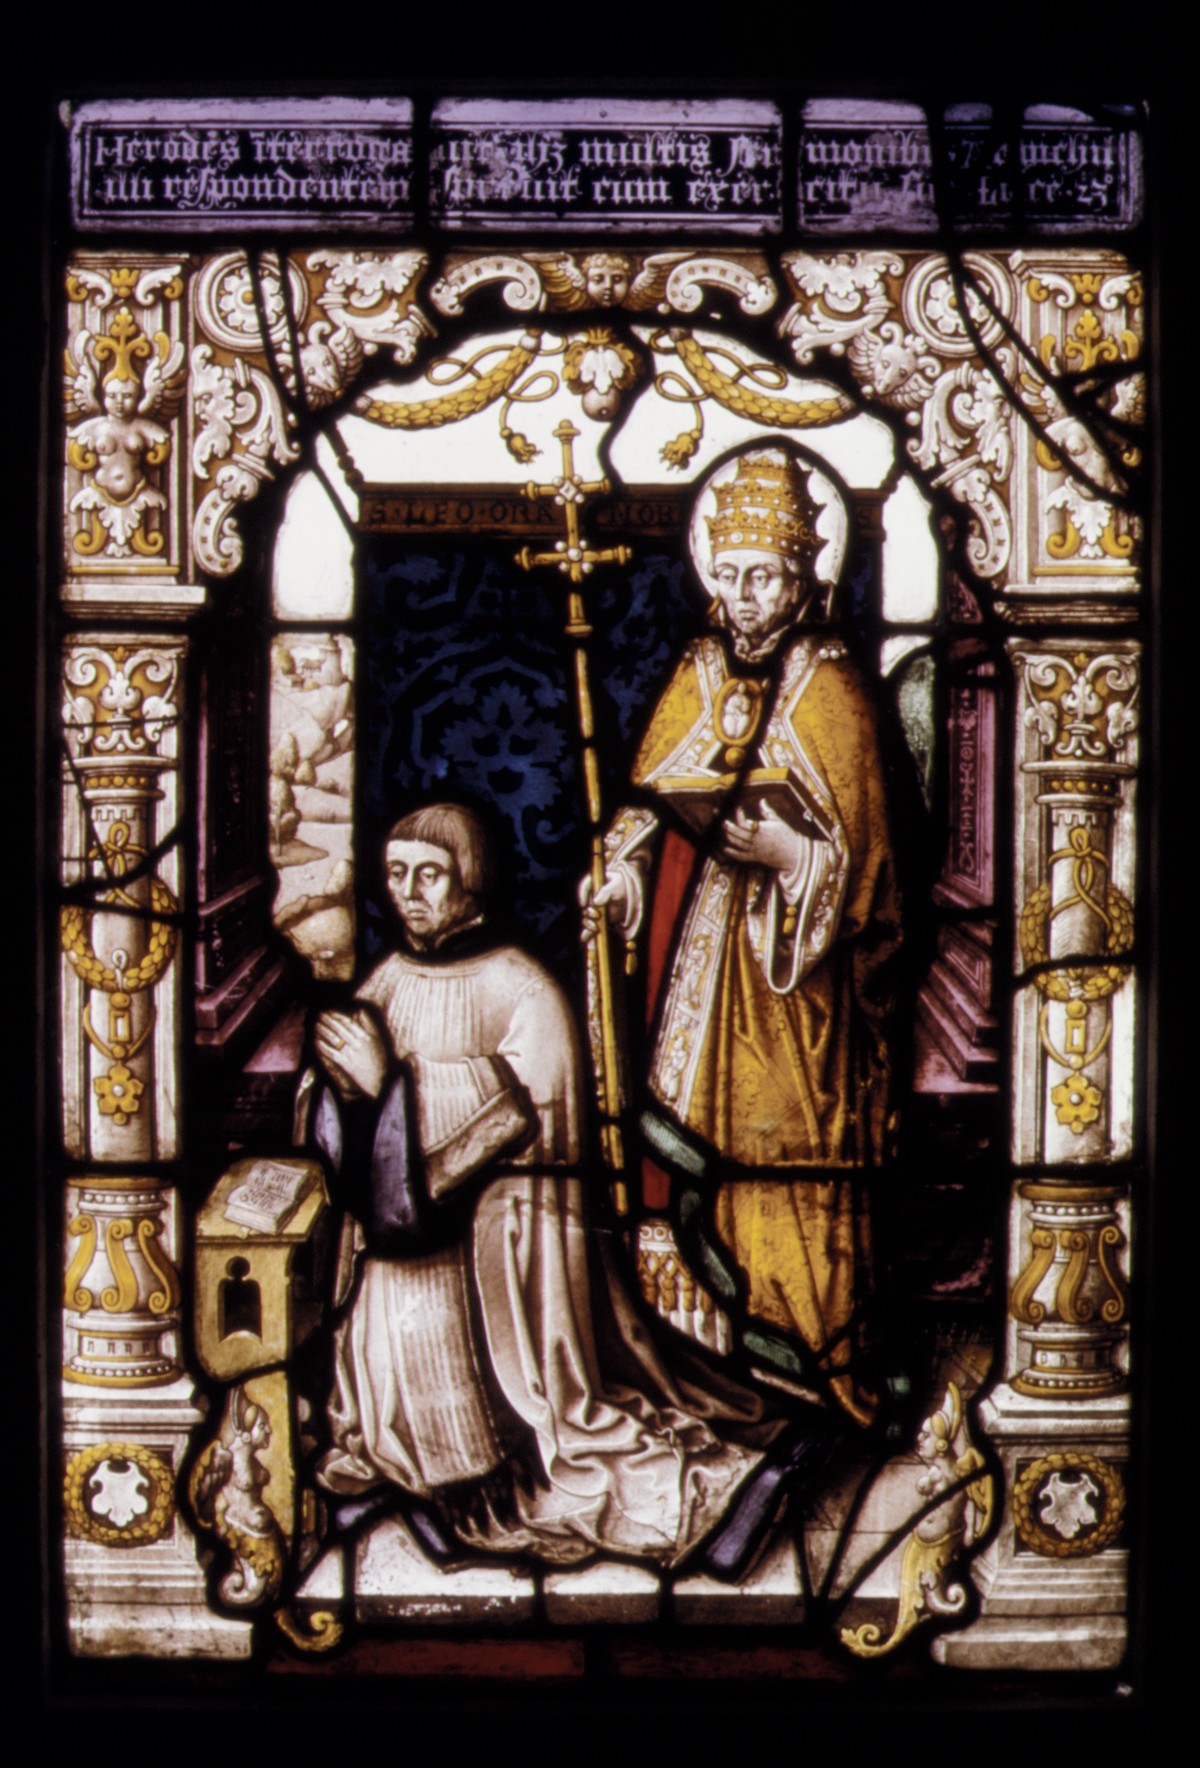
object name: panel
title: Saint Leo and a canon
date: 1525-1530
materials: glass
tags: men,saints